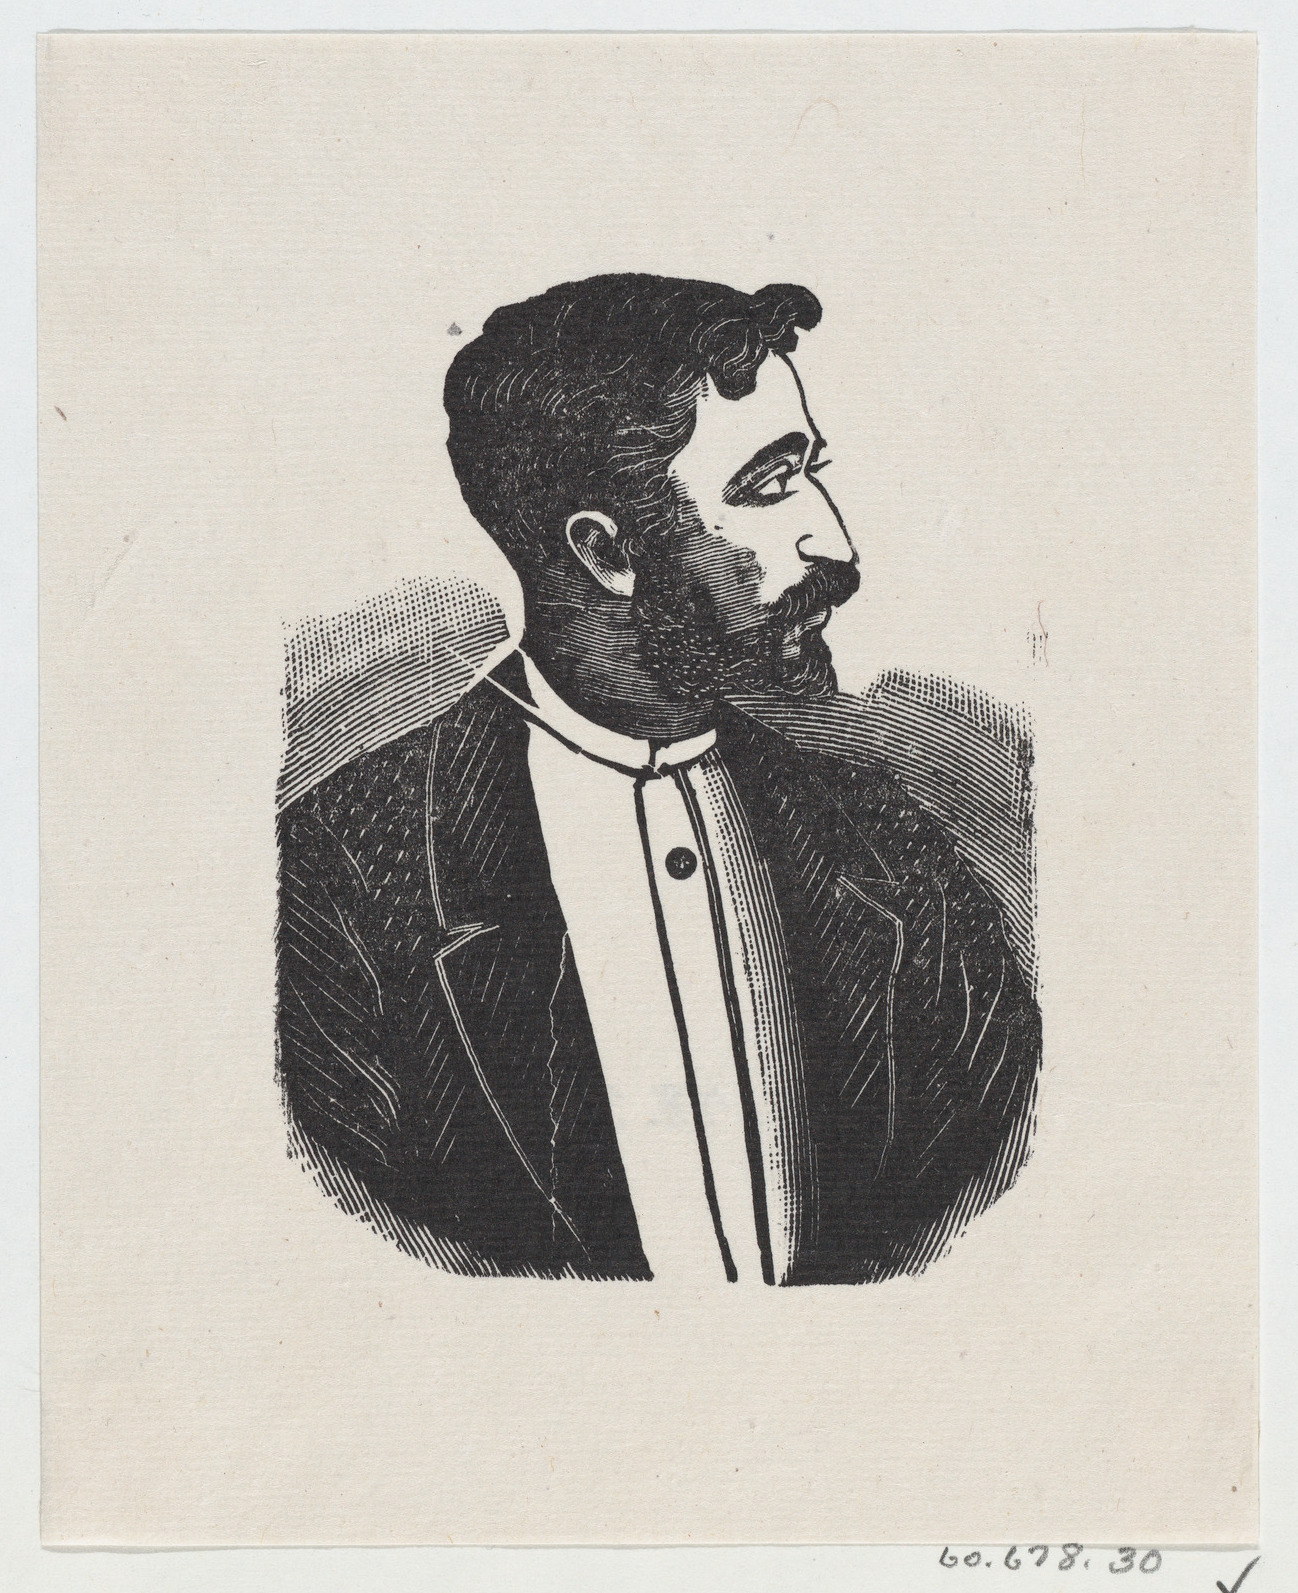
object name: print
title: Profile of a man looking to the right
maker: josé guadalupe posada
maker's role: artist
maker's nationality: mexican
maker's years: 1852-1913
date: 1880-1910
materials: metal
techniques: engraving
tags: men,profiles